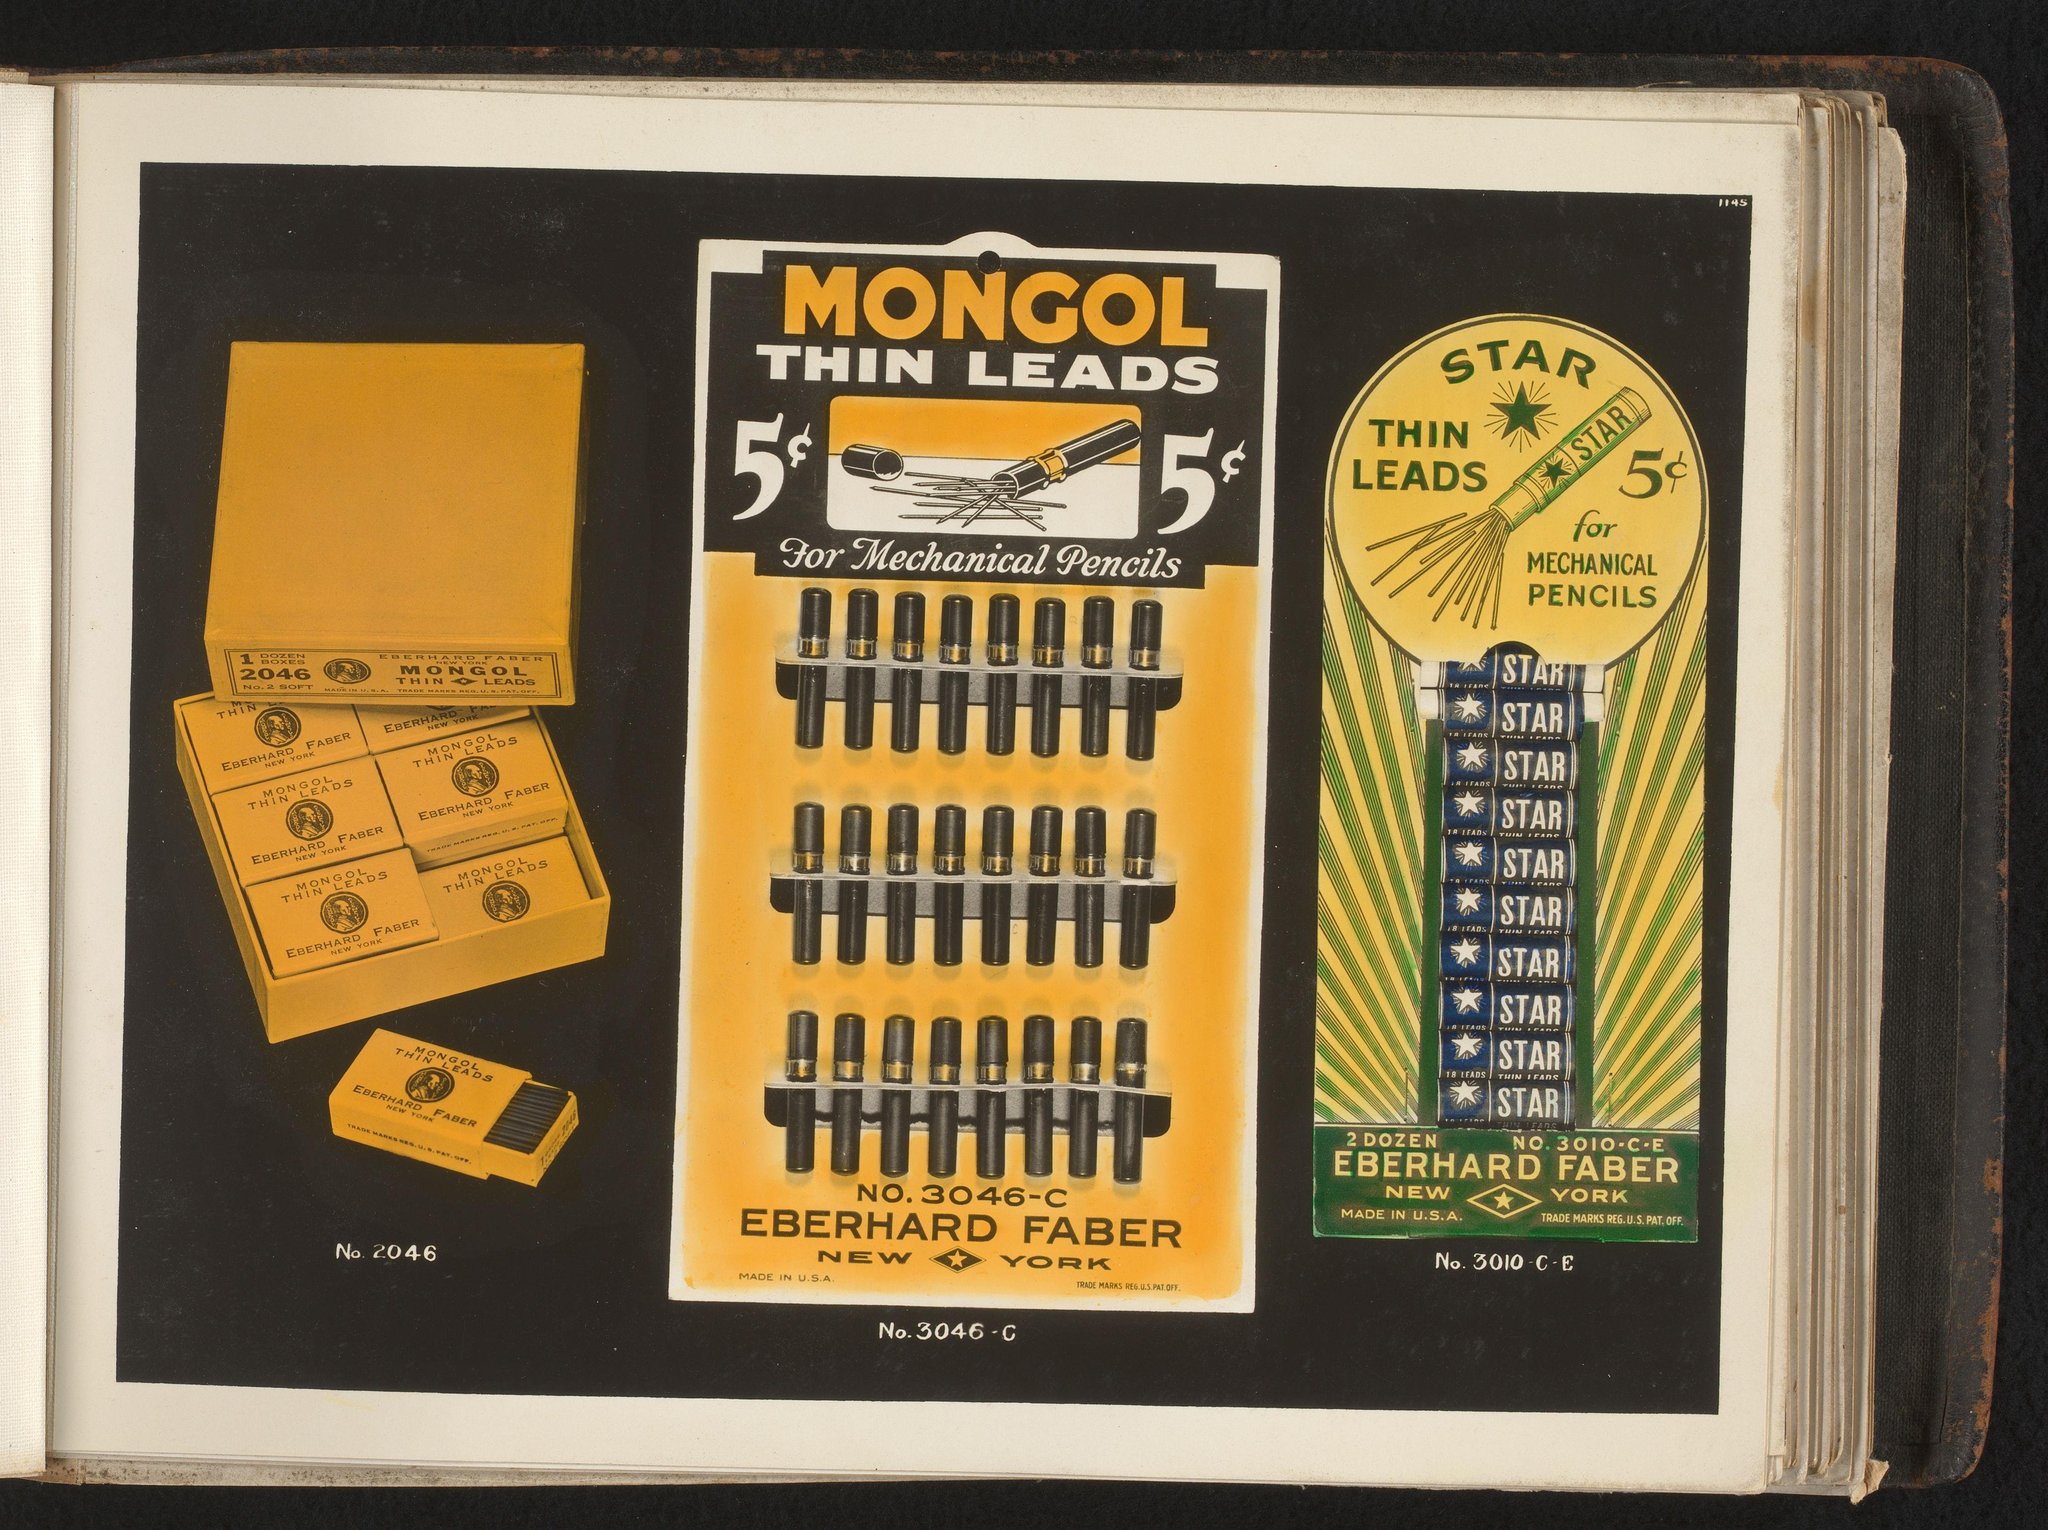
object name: album leaf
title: Standaarden met schrijfwaren van Eberhard Faber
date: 1915-1935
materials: paper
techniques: gelatin silver print, hand coloring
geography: springfield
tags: writing tools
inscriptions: number: ‘1145’, stamp: ‘Paramount/ Commercial Studios/ 145 Chestnut St./ Springfield - Mass.’